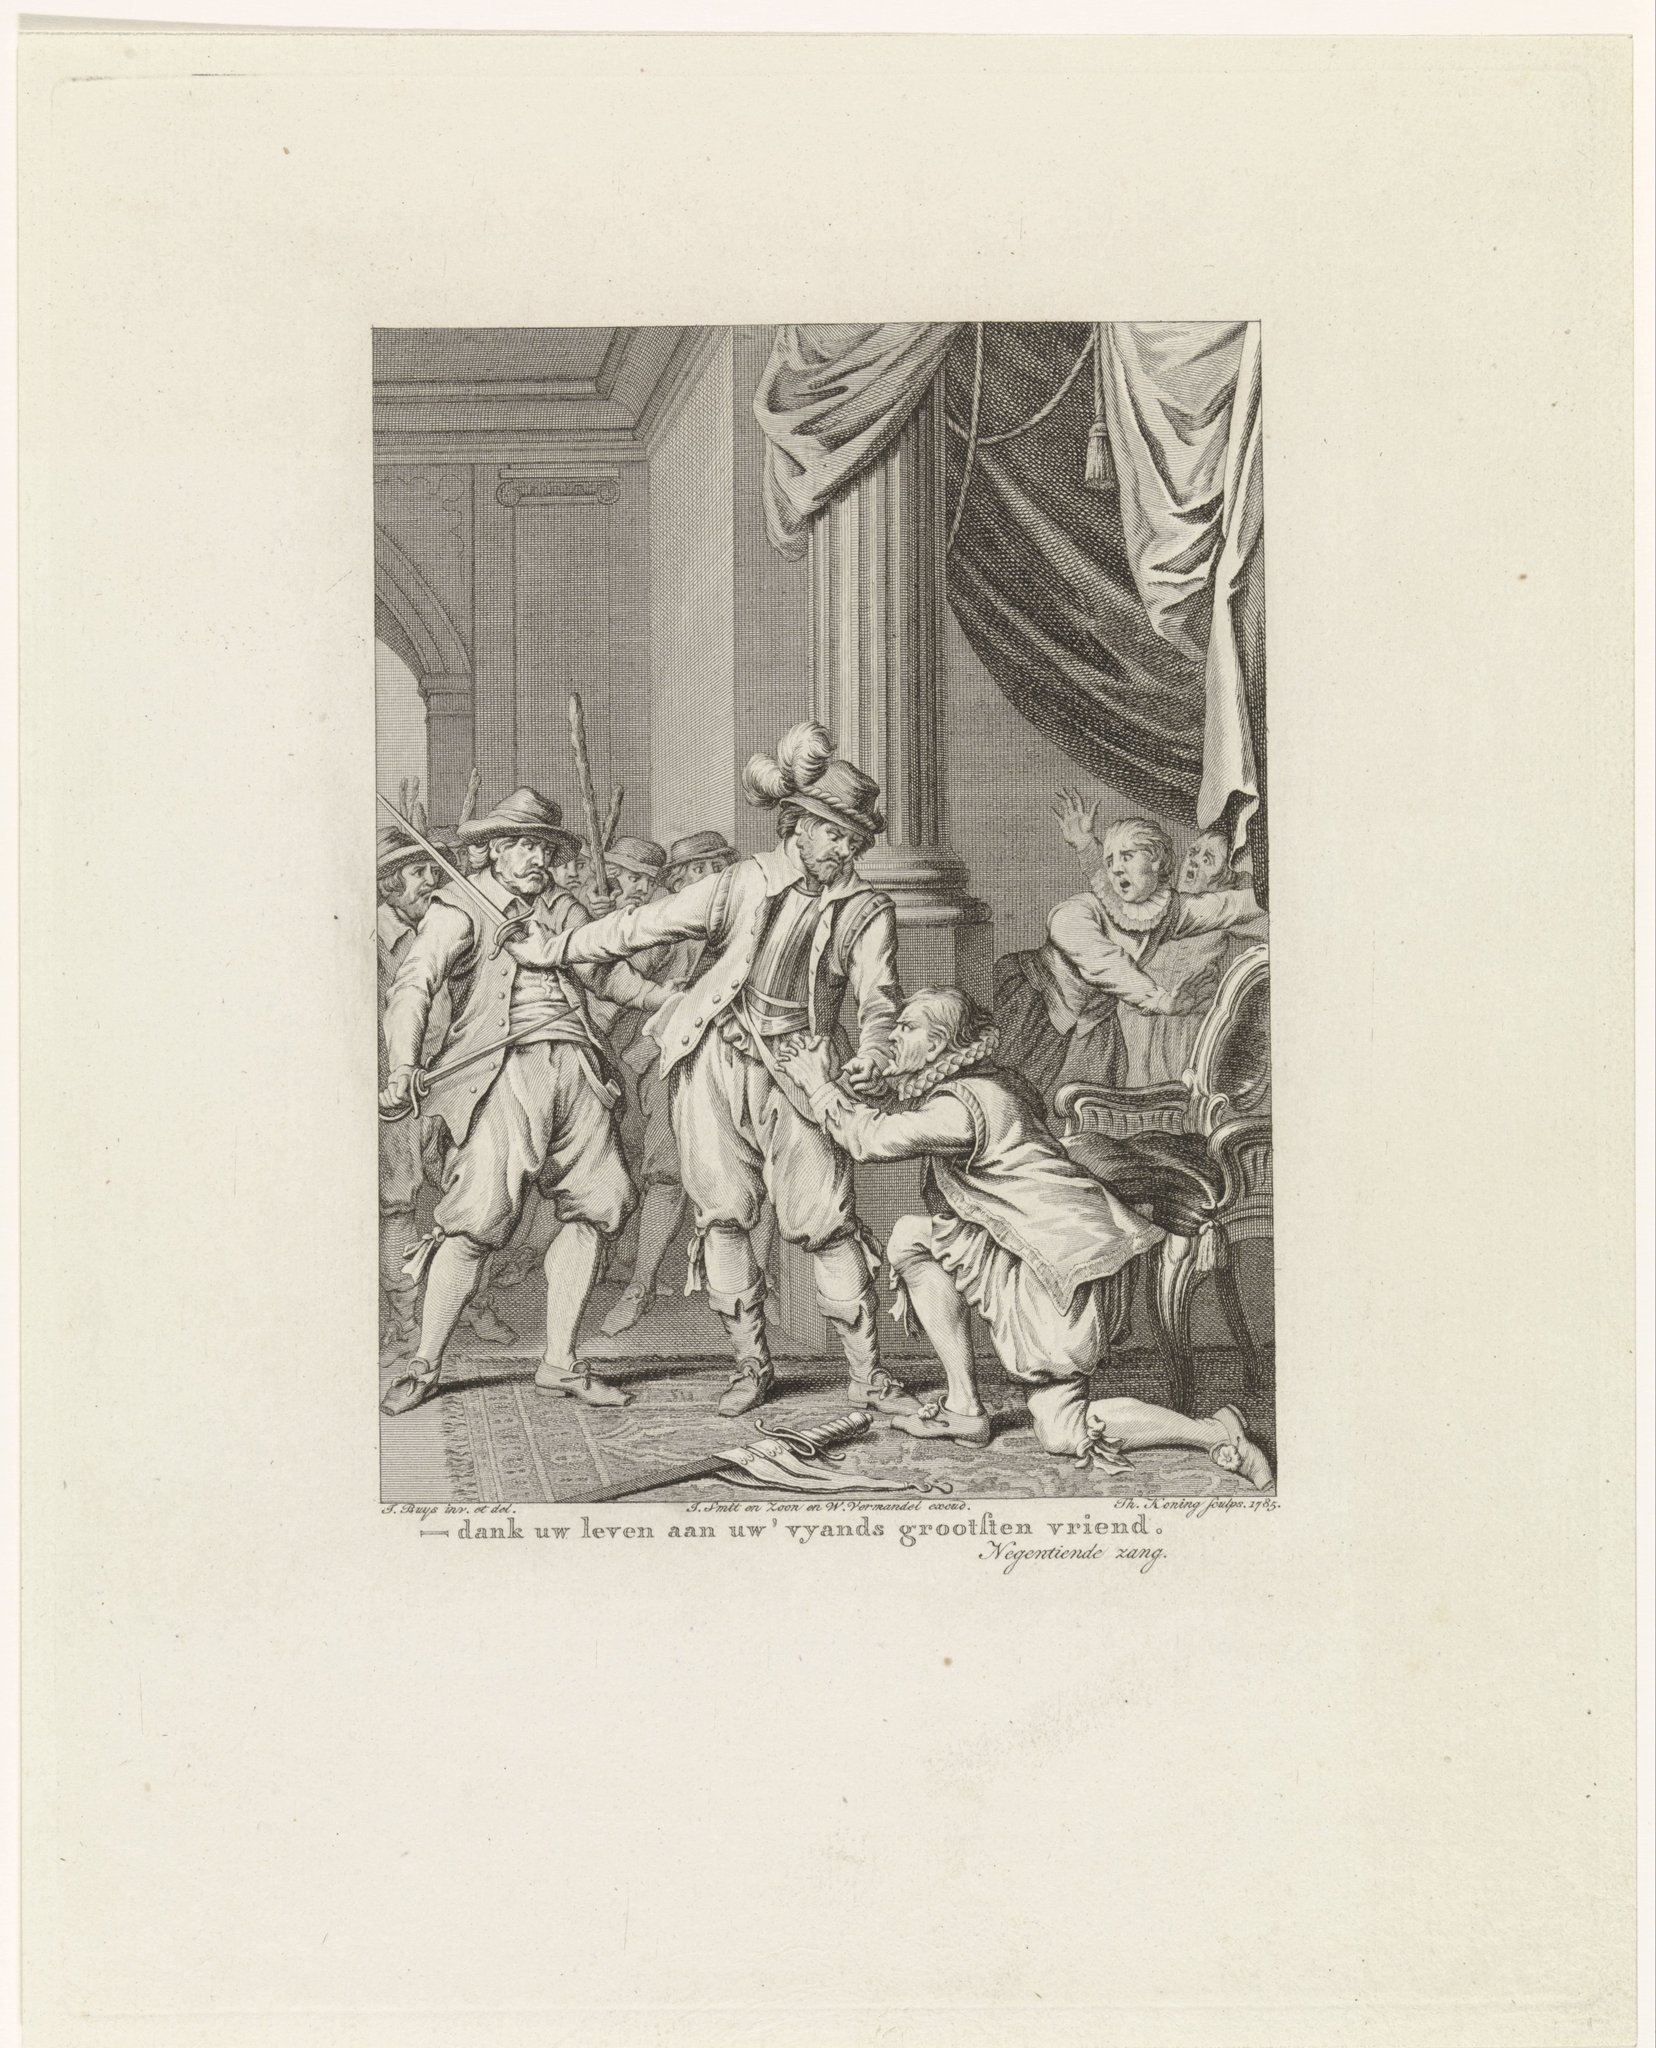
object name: history print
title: Gy kunt, dus spreekt de held, in my een schutsheer vinden:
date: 1785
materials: paper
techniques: engraving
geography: amsterdam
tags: utrecht, ghent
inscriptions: collector's mark: Lugt 2228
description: Aerschot, burgemeester van Gent, wordt beschermd door François van Ryhove tegen de opstandige inwoners die hem met knuppels en zwaarden te lijf willen gaan, 1577. Deze prent maakt deel uit van een serie van 24 prenten met taferelen uit het leven van prins Willem I, 1568-1584 en is een illustratie bij de negentiende zang.